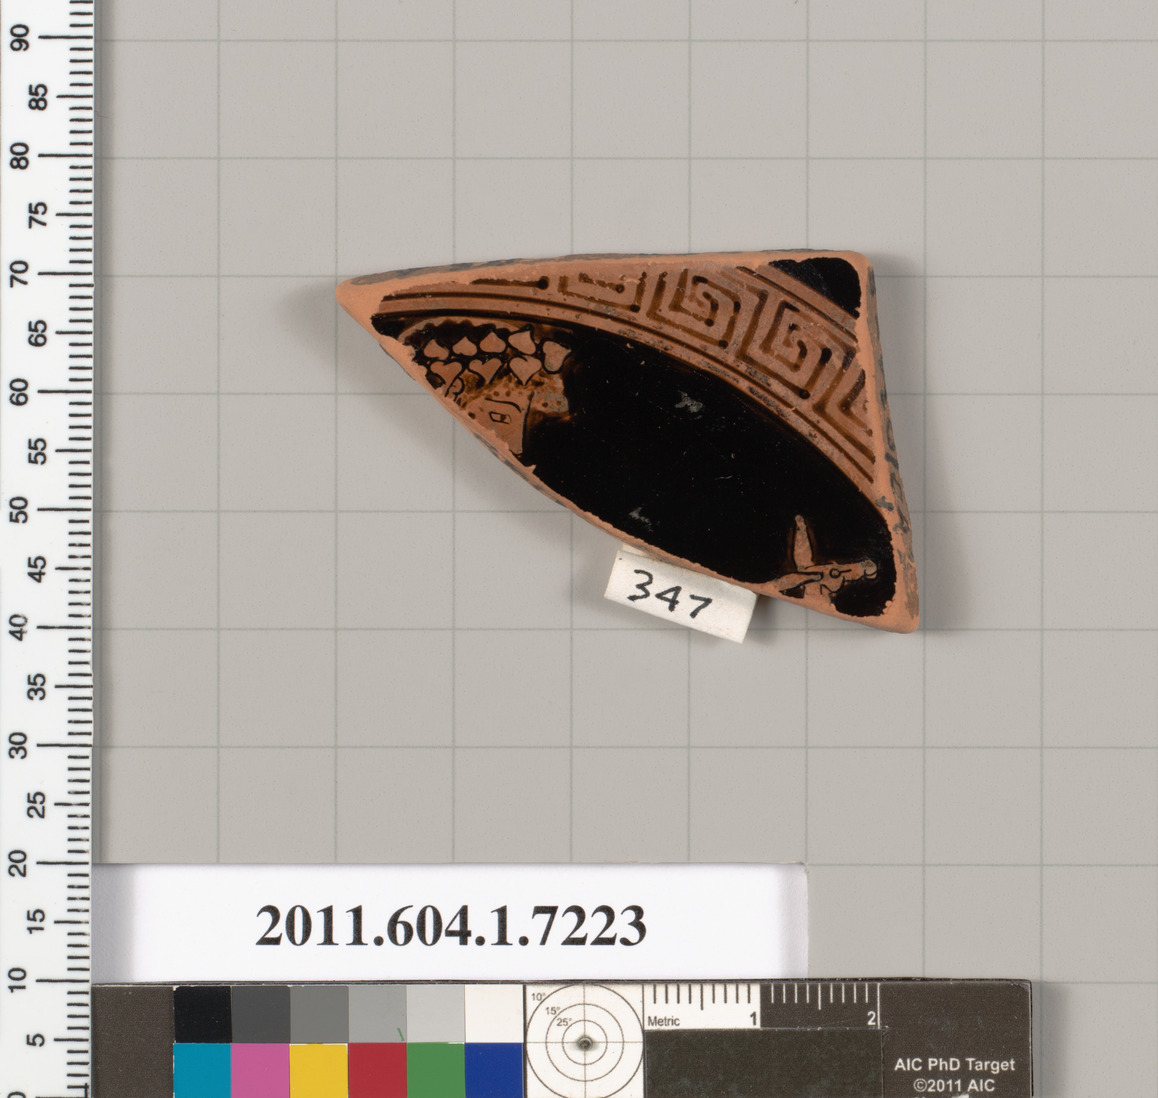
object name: kylix fragment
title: Terracotta fragment of a kylix (drinking cup)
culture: greek, attic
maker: makron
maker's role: artist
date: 500-480 BCE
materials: terracotta